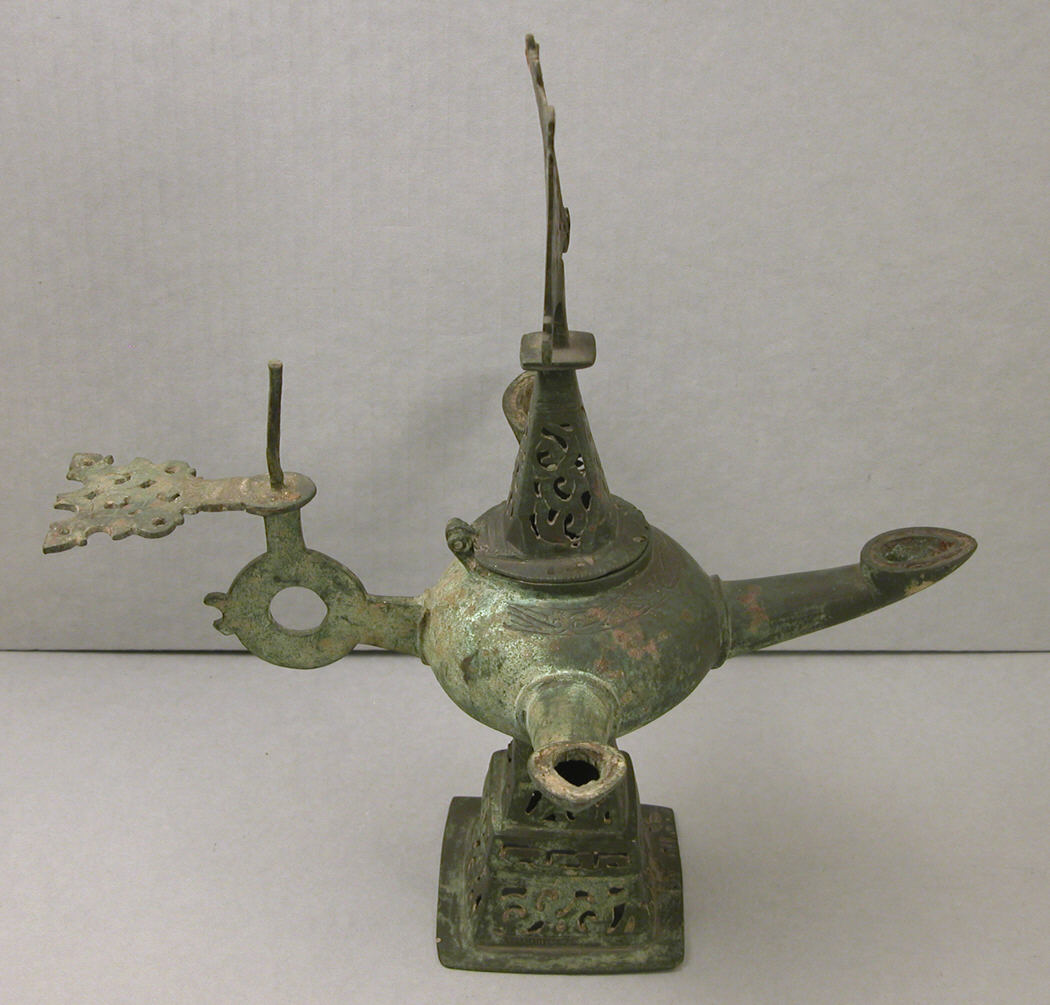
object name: lamp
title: Three-Spouted Oil Lamp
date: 1101-1300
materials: bronze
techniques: casting, engraving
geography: iran